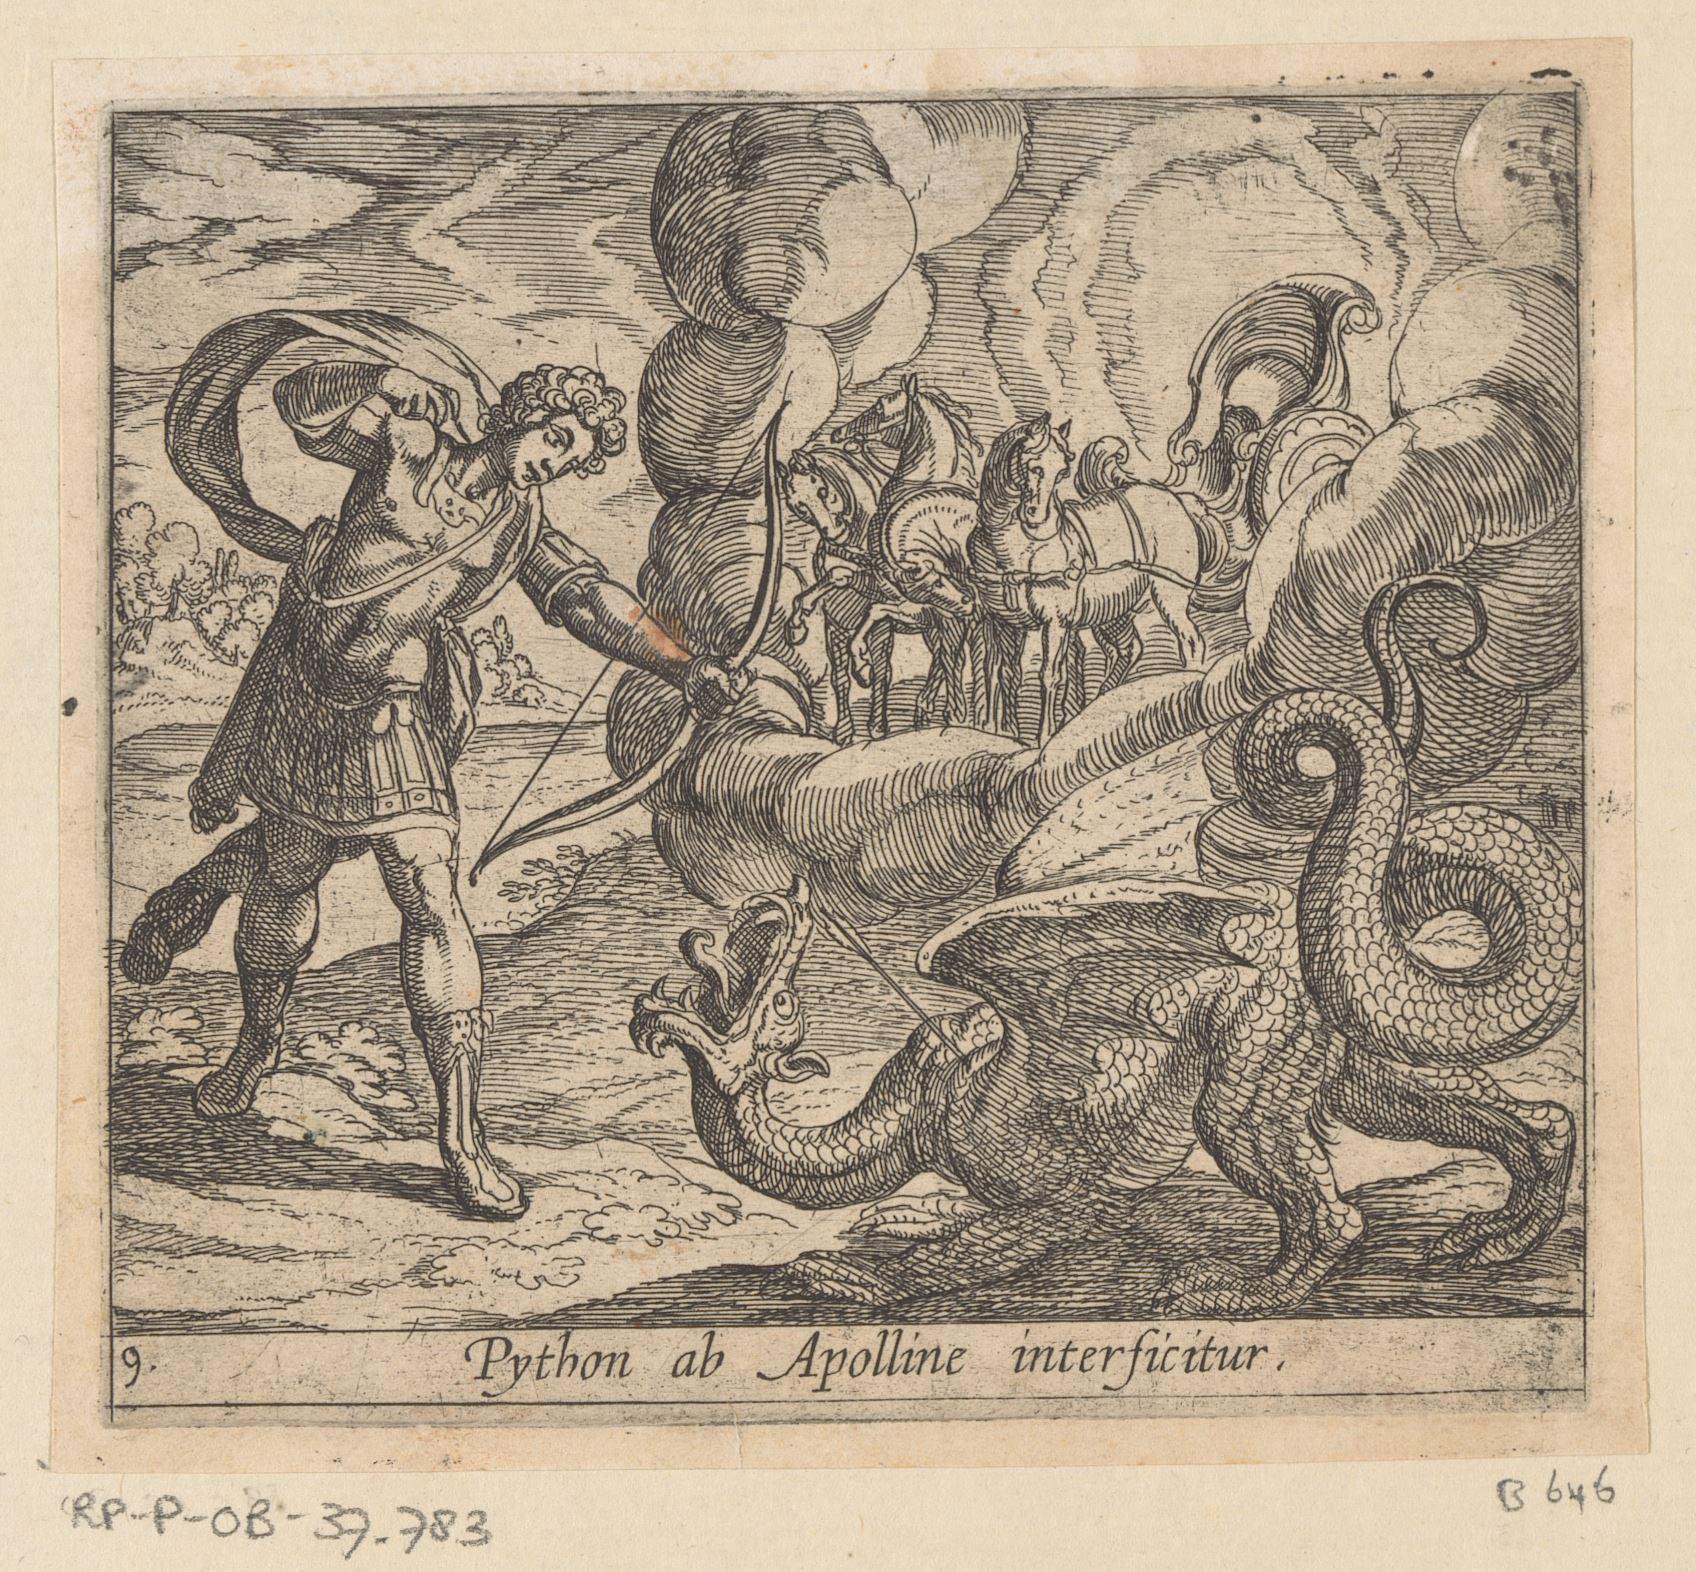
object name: print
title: Python ab Apolline interficitur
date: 1606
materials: paper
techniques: etching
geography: italy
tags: apollo shoots python, the dragon, (story of) apollo (phoebus)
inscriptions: collector's mark: Lugt 240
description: Apollo schiet met pijl-en-boog op Python. Op de achtergrond de zonnewagen van Apollo met vier paarden. Titel in het Latijn in ondermarge.